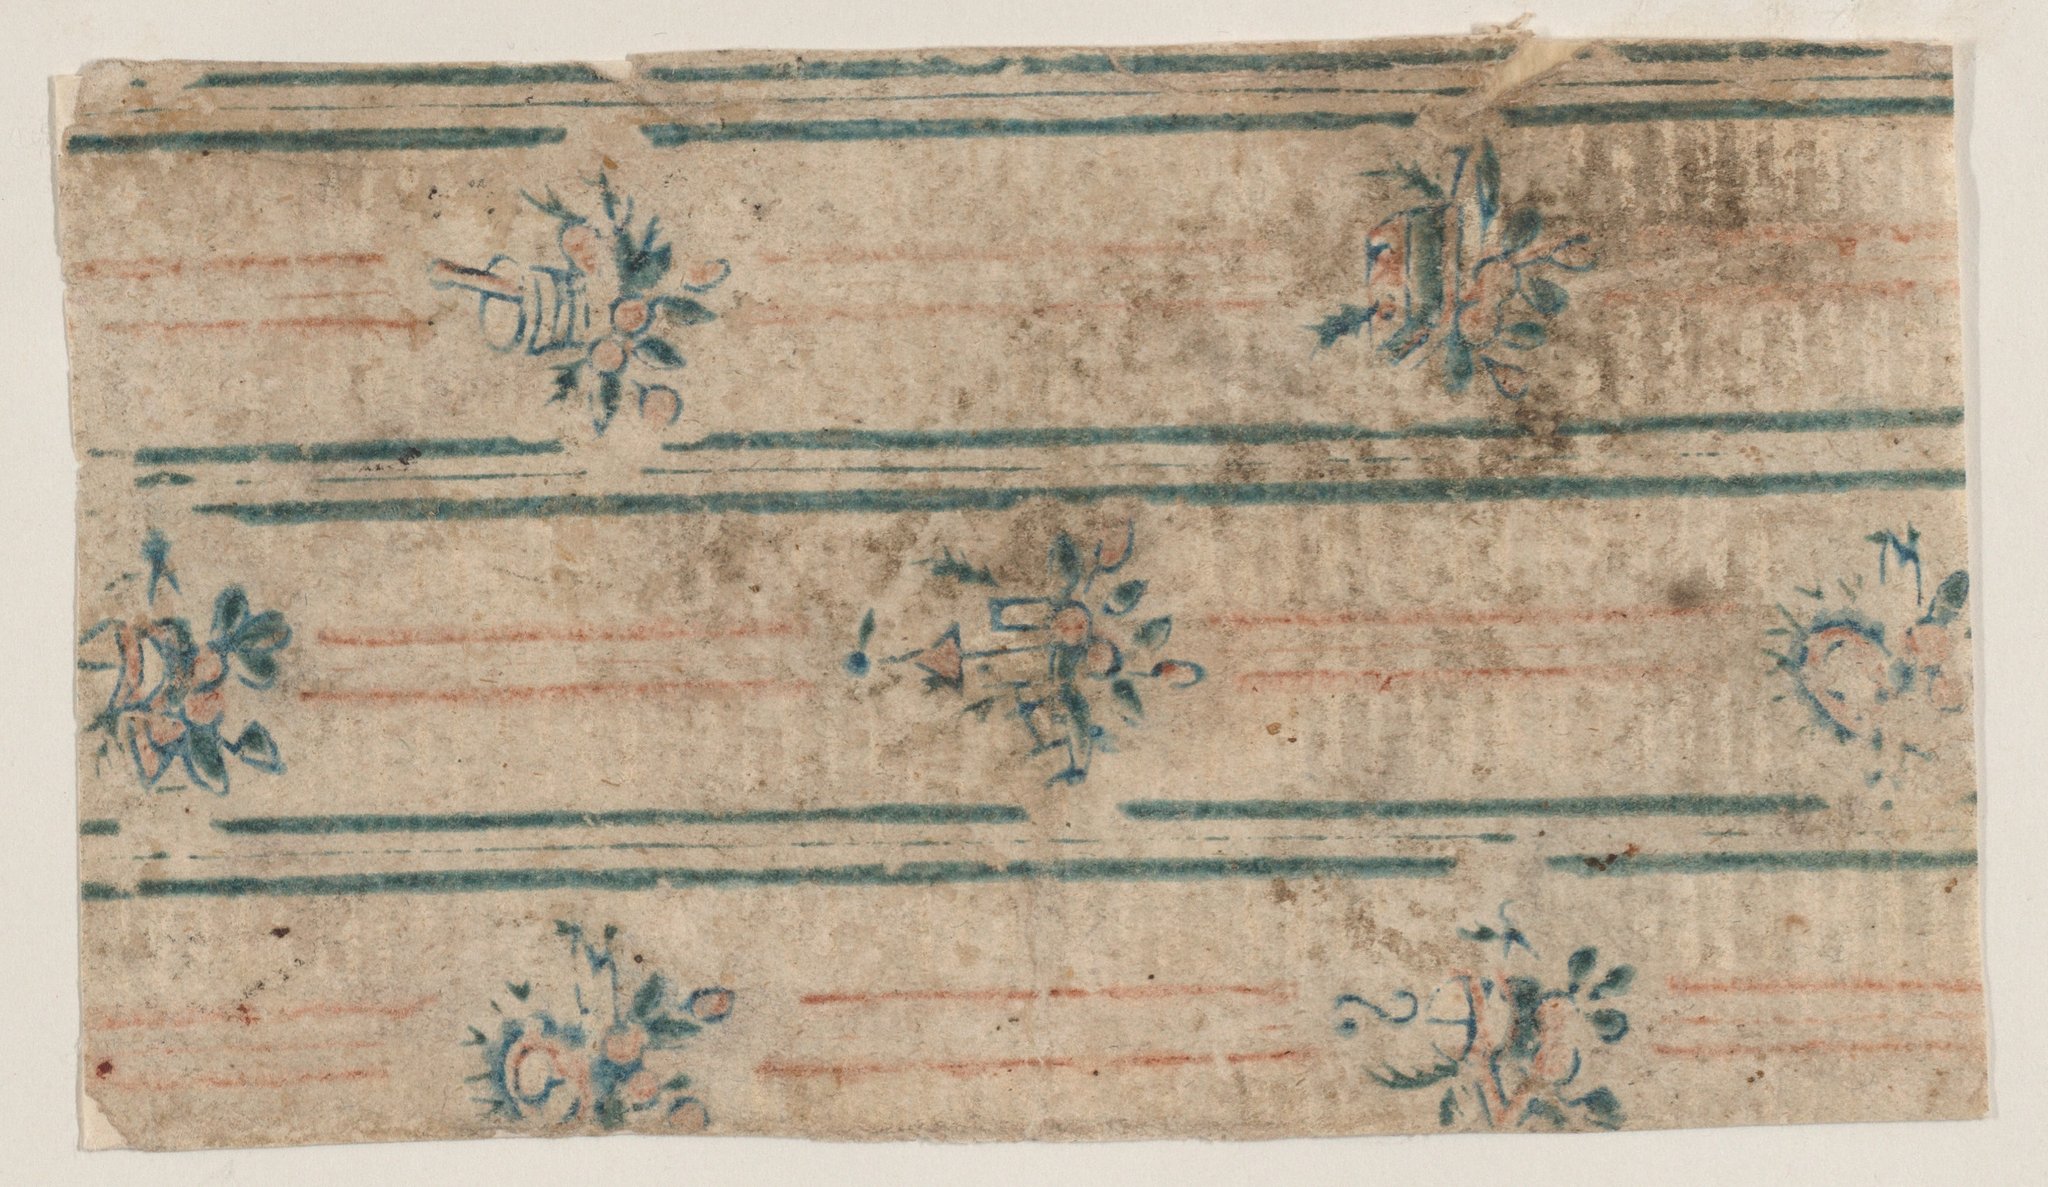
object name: print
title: Sheet with two borders with floral and geometric patterns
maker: Anonymous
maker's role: artist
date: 1801-1900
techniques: relief print